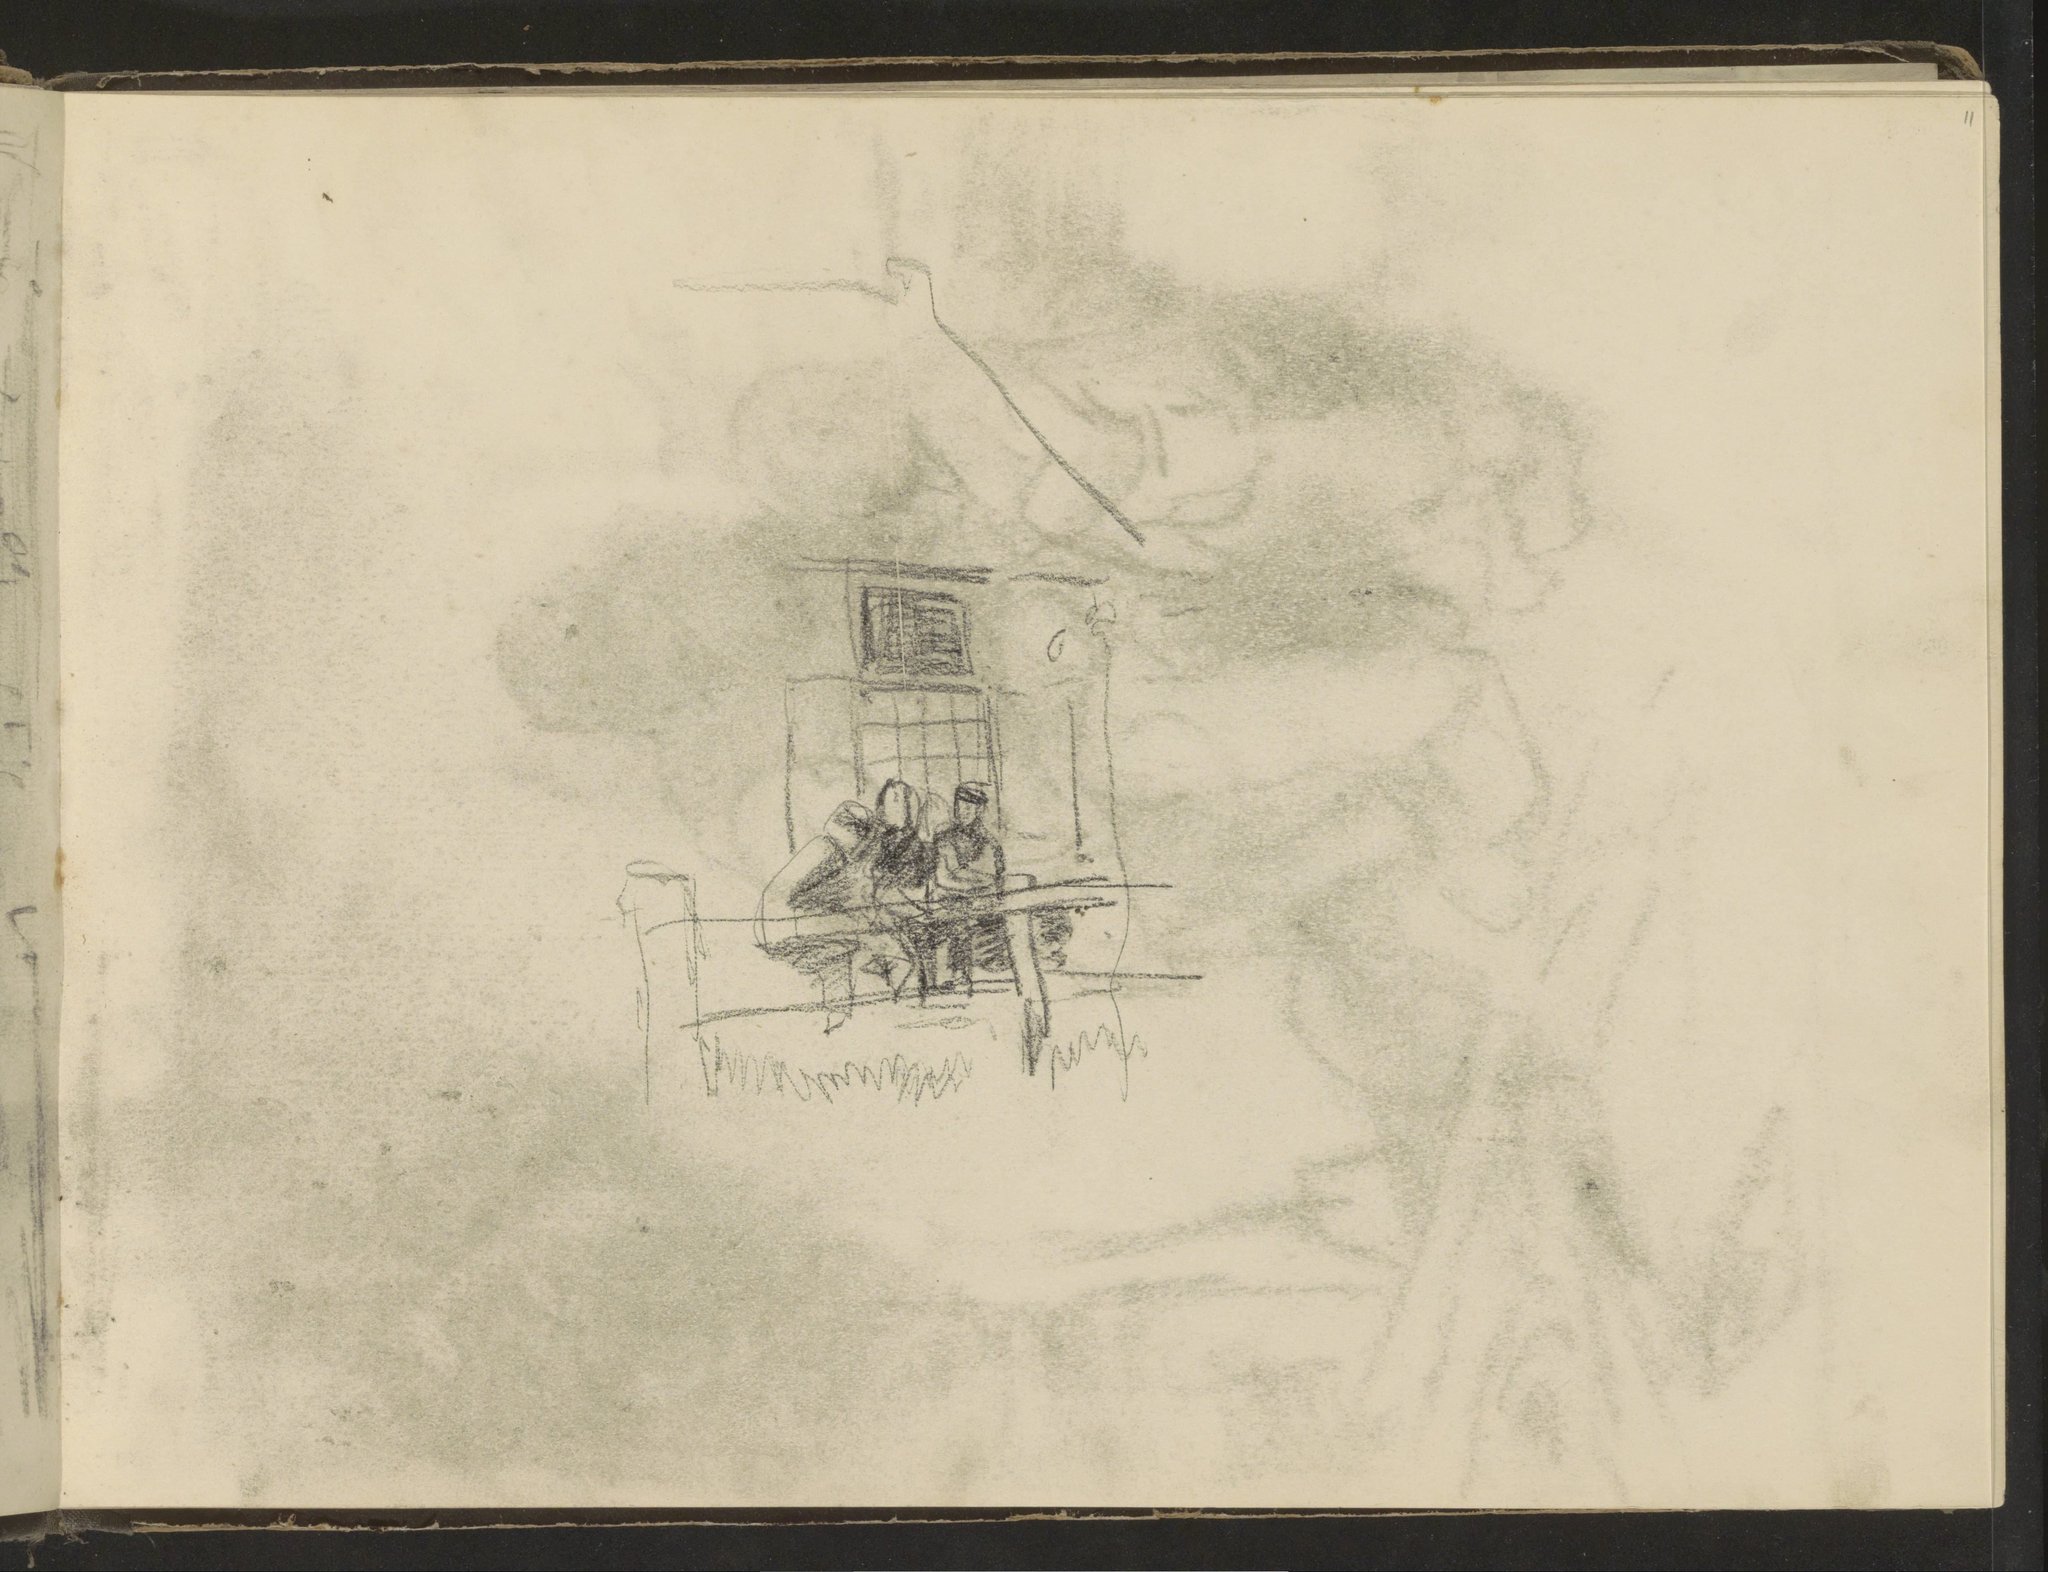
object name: sketchbook leaf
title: Drie figuren bij een hek voor een boerenwoning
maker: albert neuhuys (1844-1914)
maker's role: draughtsman, painter, print maker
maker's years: 1844-1914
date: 1854-1914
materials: chalk, paper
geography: laren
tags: anatomy (non-medical), fence, wall, paling, rural housing, e.g. country-house, villa, cottage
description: Blad 11 recto uit een schetsboek met 43 bladen.